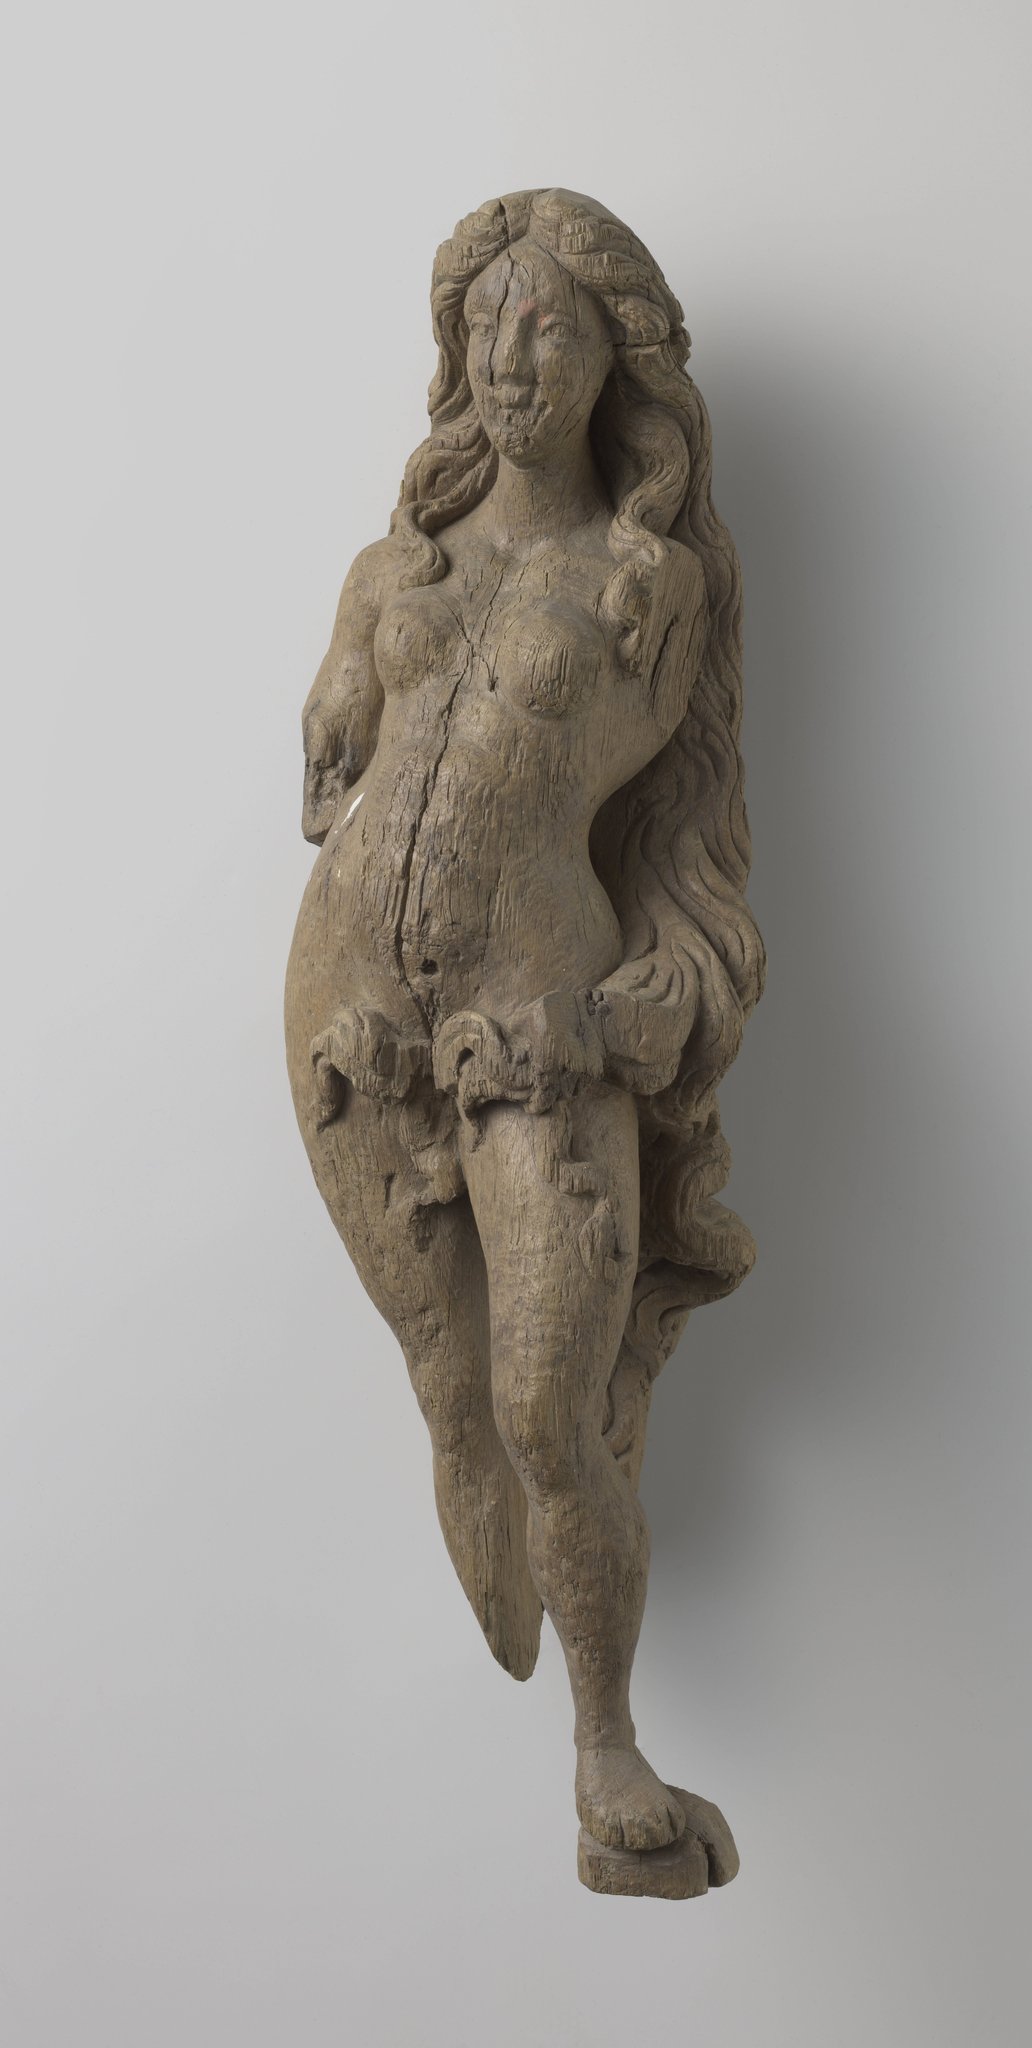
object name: architectural element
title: Zeemeermin van hout, afkomstig van één van de poorten van de kleine of O.L.Vr. kerk te Edam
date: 1300-1550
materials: wood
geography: edam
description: Een houten zeemeermin. Afkomstig van één van de poorten aan de kleine (O.L. Vrouwe) kerk te Edam.